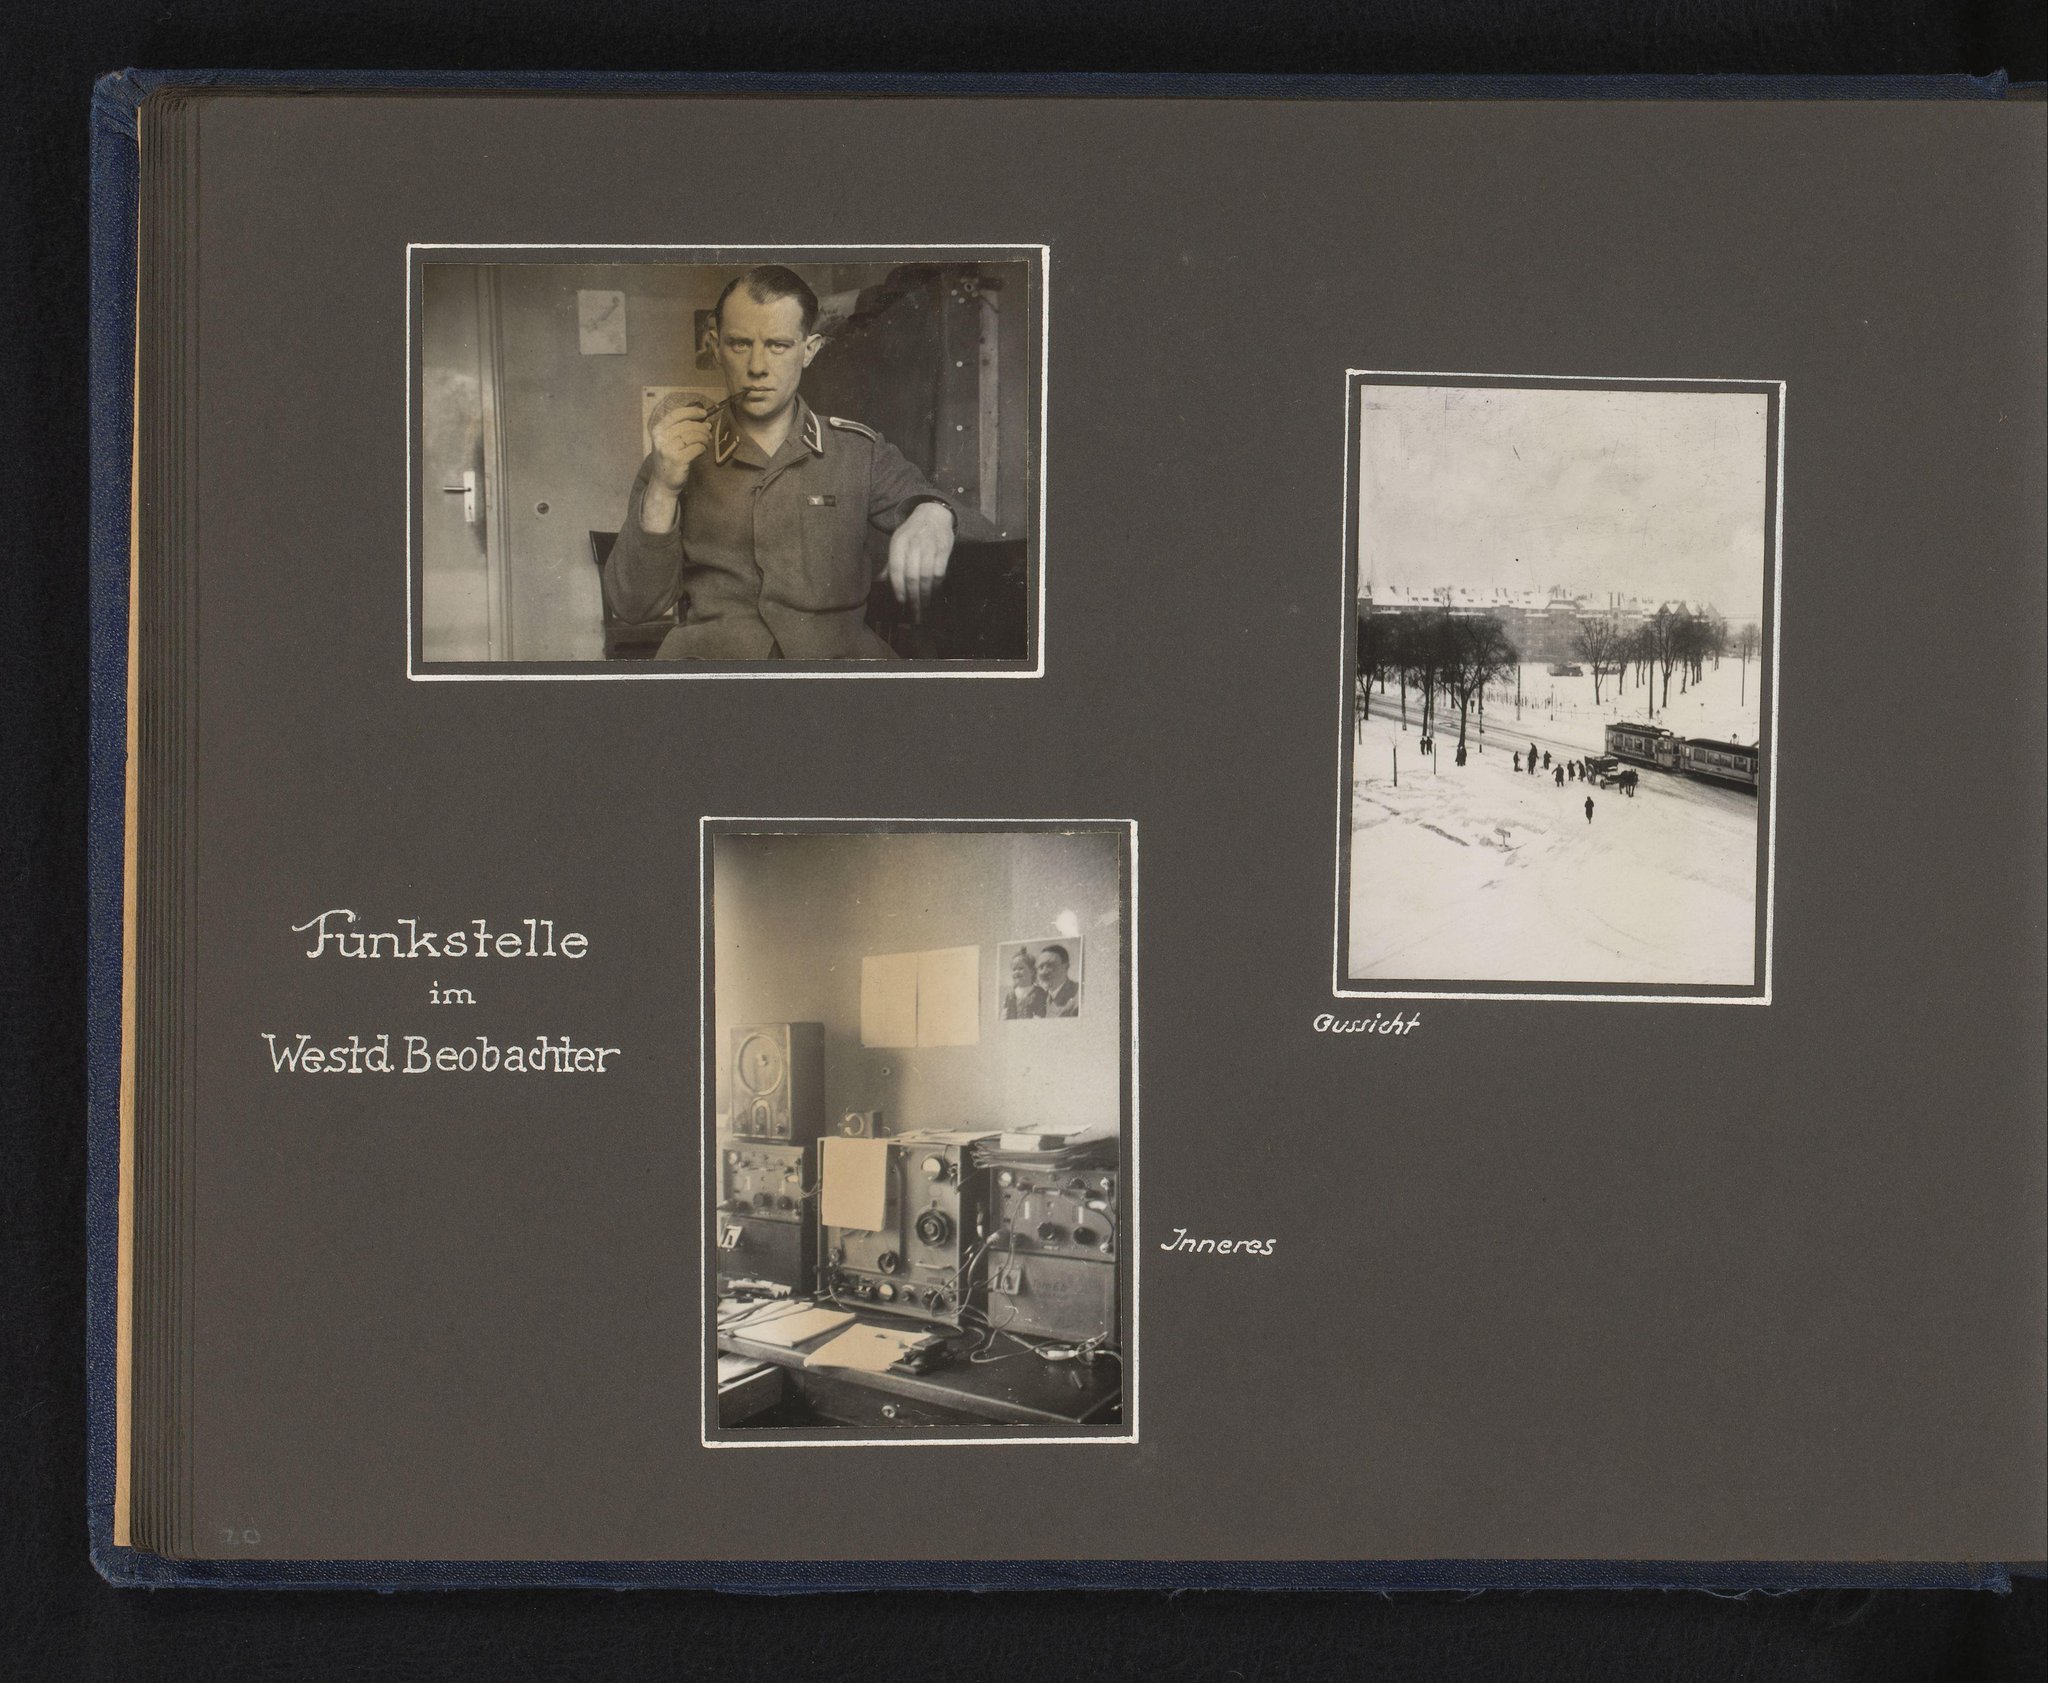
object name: photograph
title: Radioinstallatie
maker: Anonymous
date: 1939-1940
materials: paper, photographic support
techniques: gelatin silver print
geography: germany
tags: radiotelegraph, walkie-talkie, germany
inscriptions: inscription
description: Albumblad met drie foto's van een man met een pijp (mogelijk de samensteller van het album), een installatie voor radiotelegrafie bij de Westdeutscher Beobachter (NSDAP krant) en uitzicht, winter 1939-1940. Onderdeel van een Duits militair album Tweede Wereldoorlog 1939-1940.